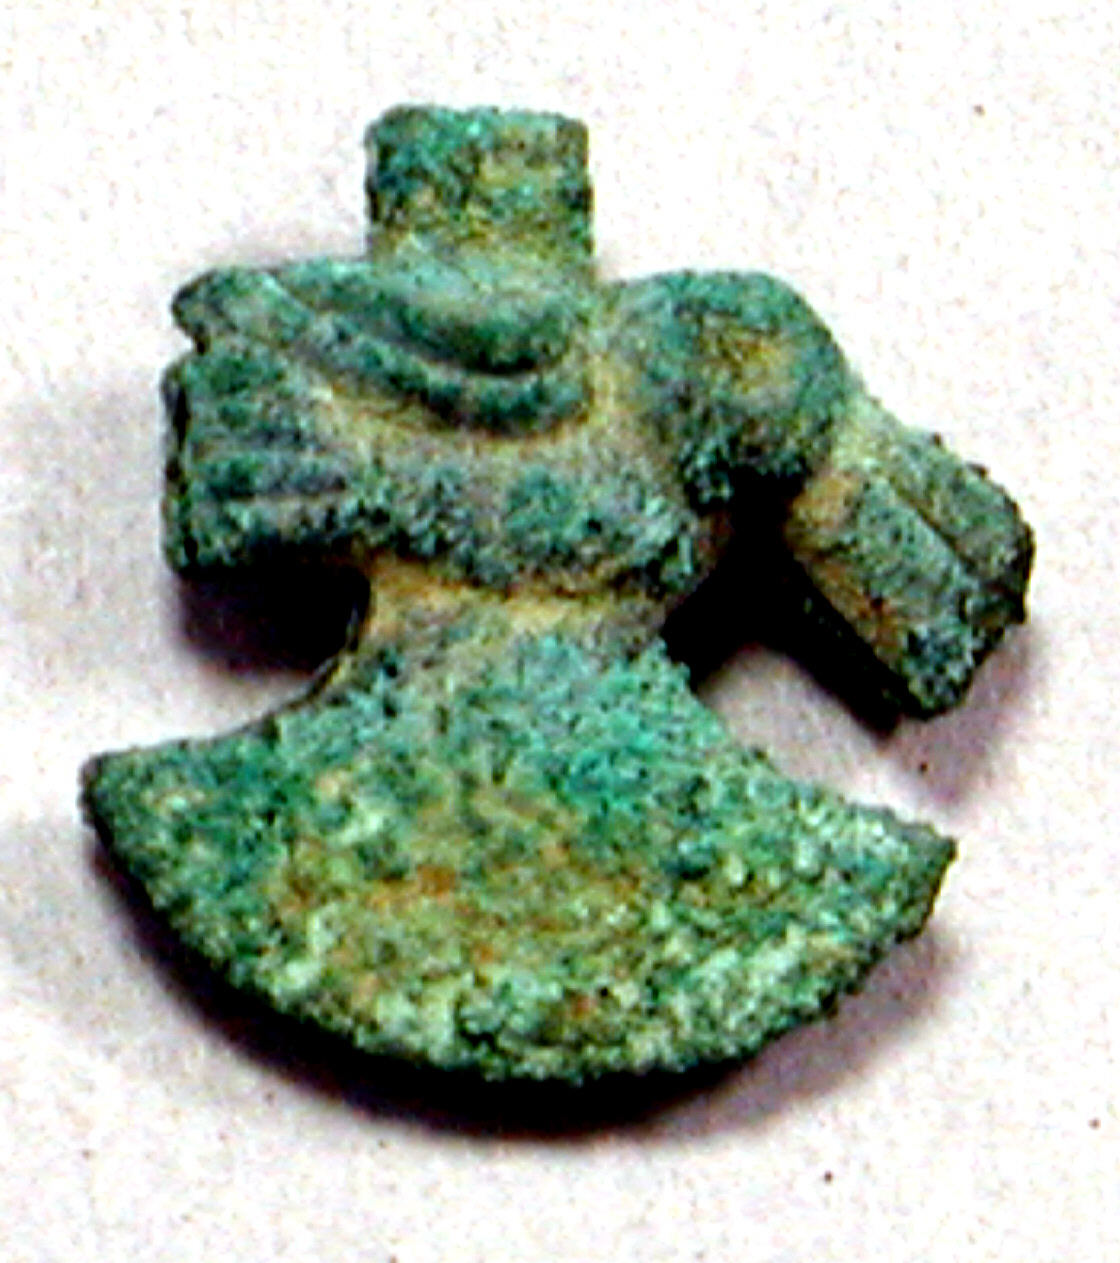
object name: tweezer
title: Copper Tweezers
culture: peruvian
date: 1401-1500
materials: copper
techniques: hammering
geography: peru